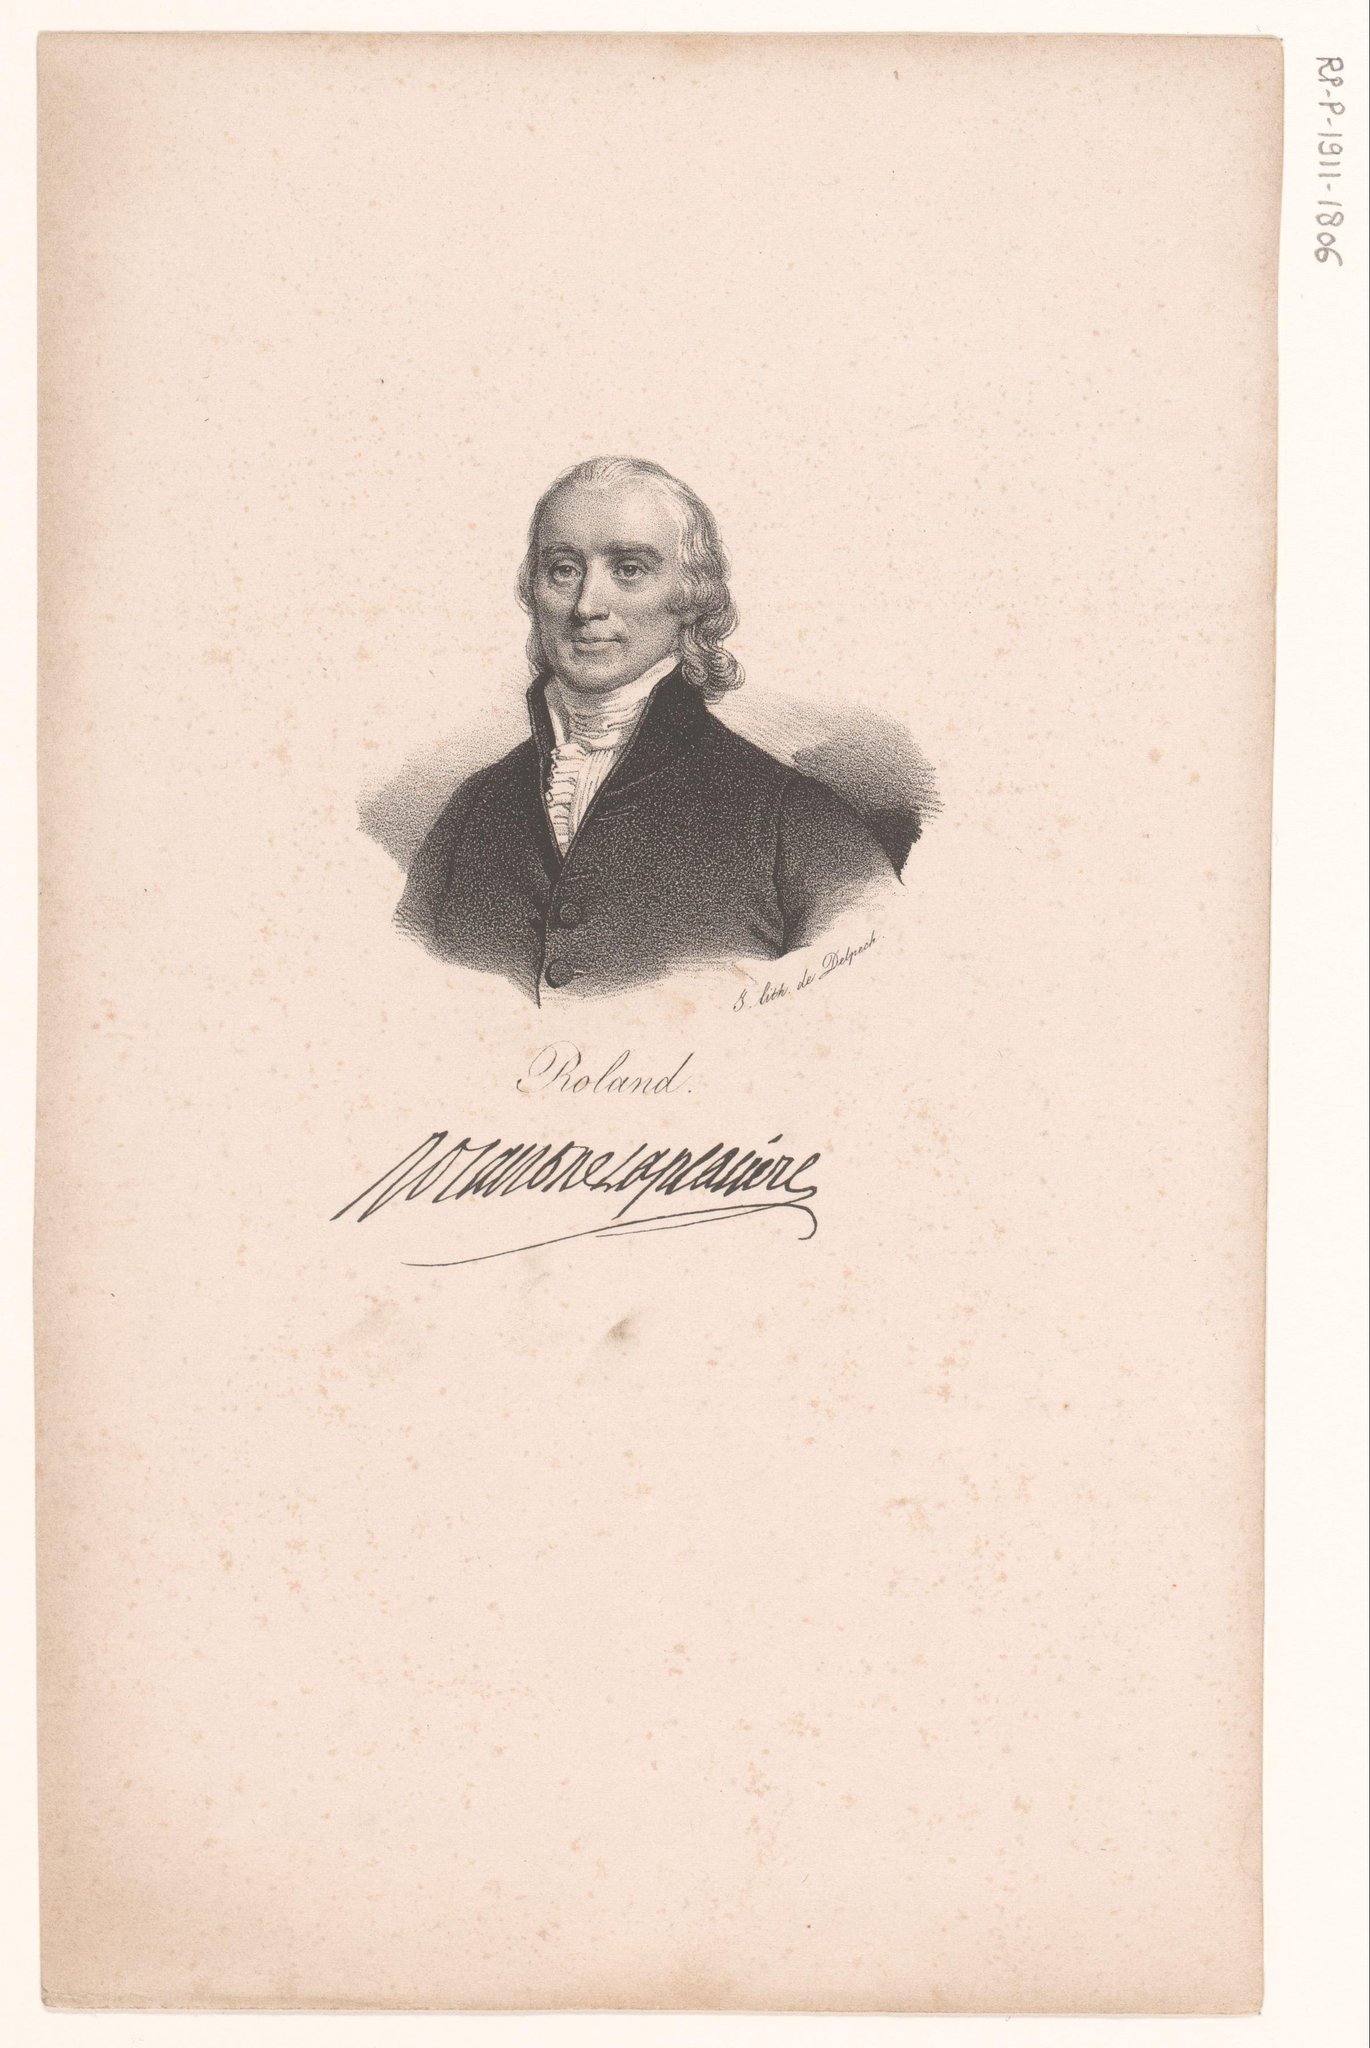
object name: print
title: Roland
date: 1818-1842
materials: paper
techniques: lithograph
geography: paris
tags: historical persons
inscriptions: collector's mark: Lugt 2228a